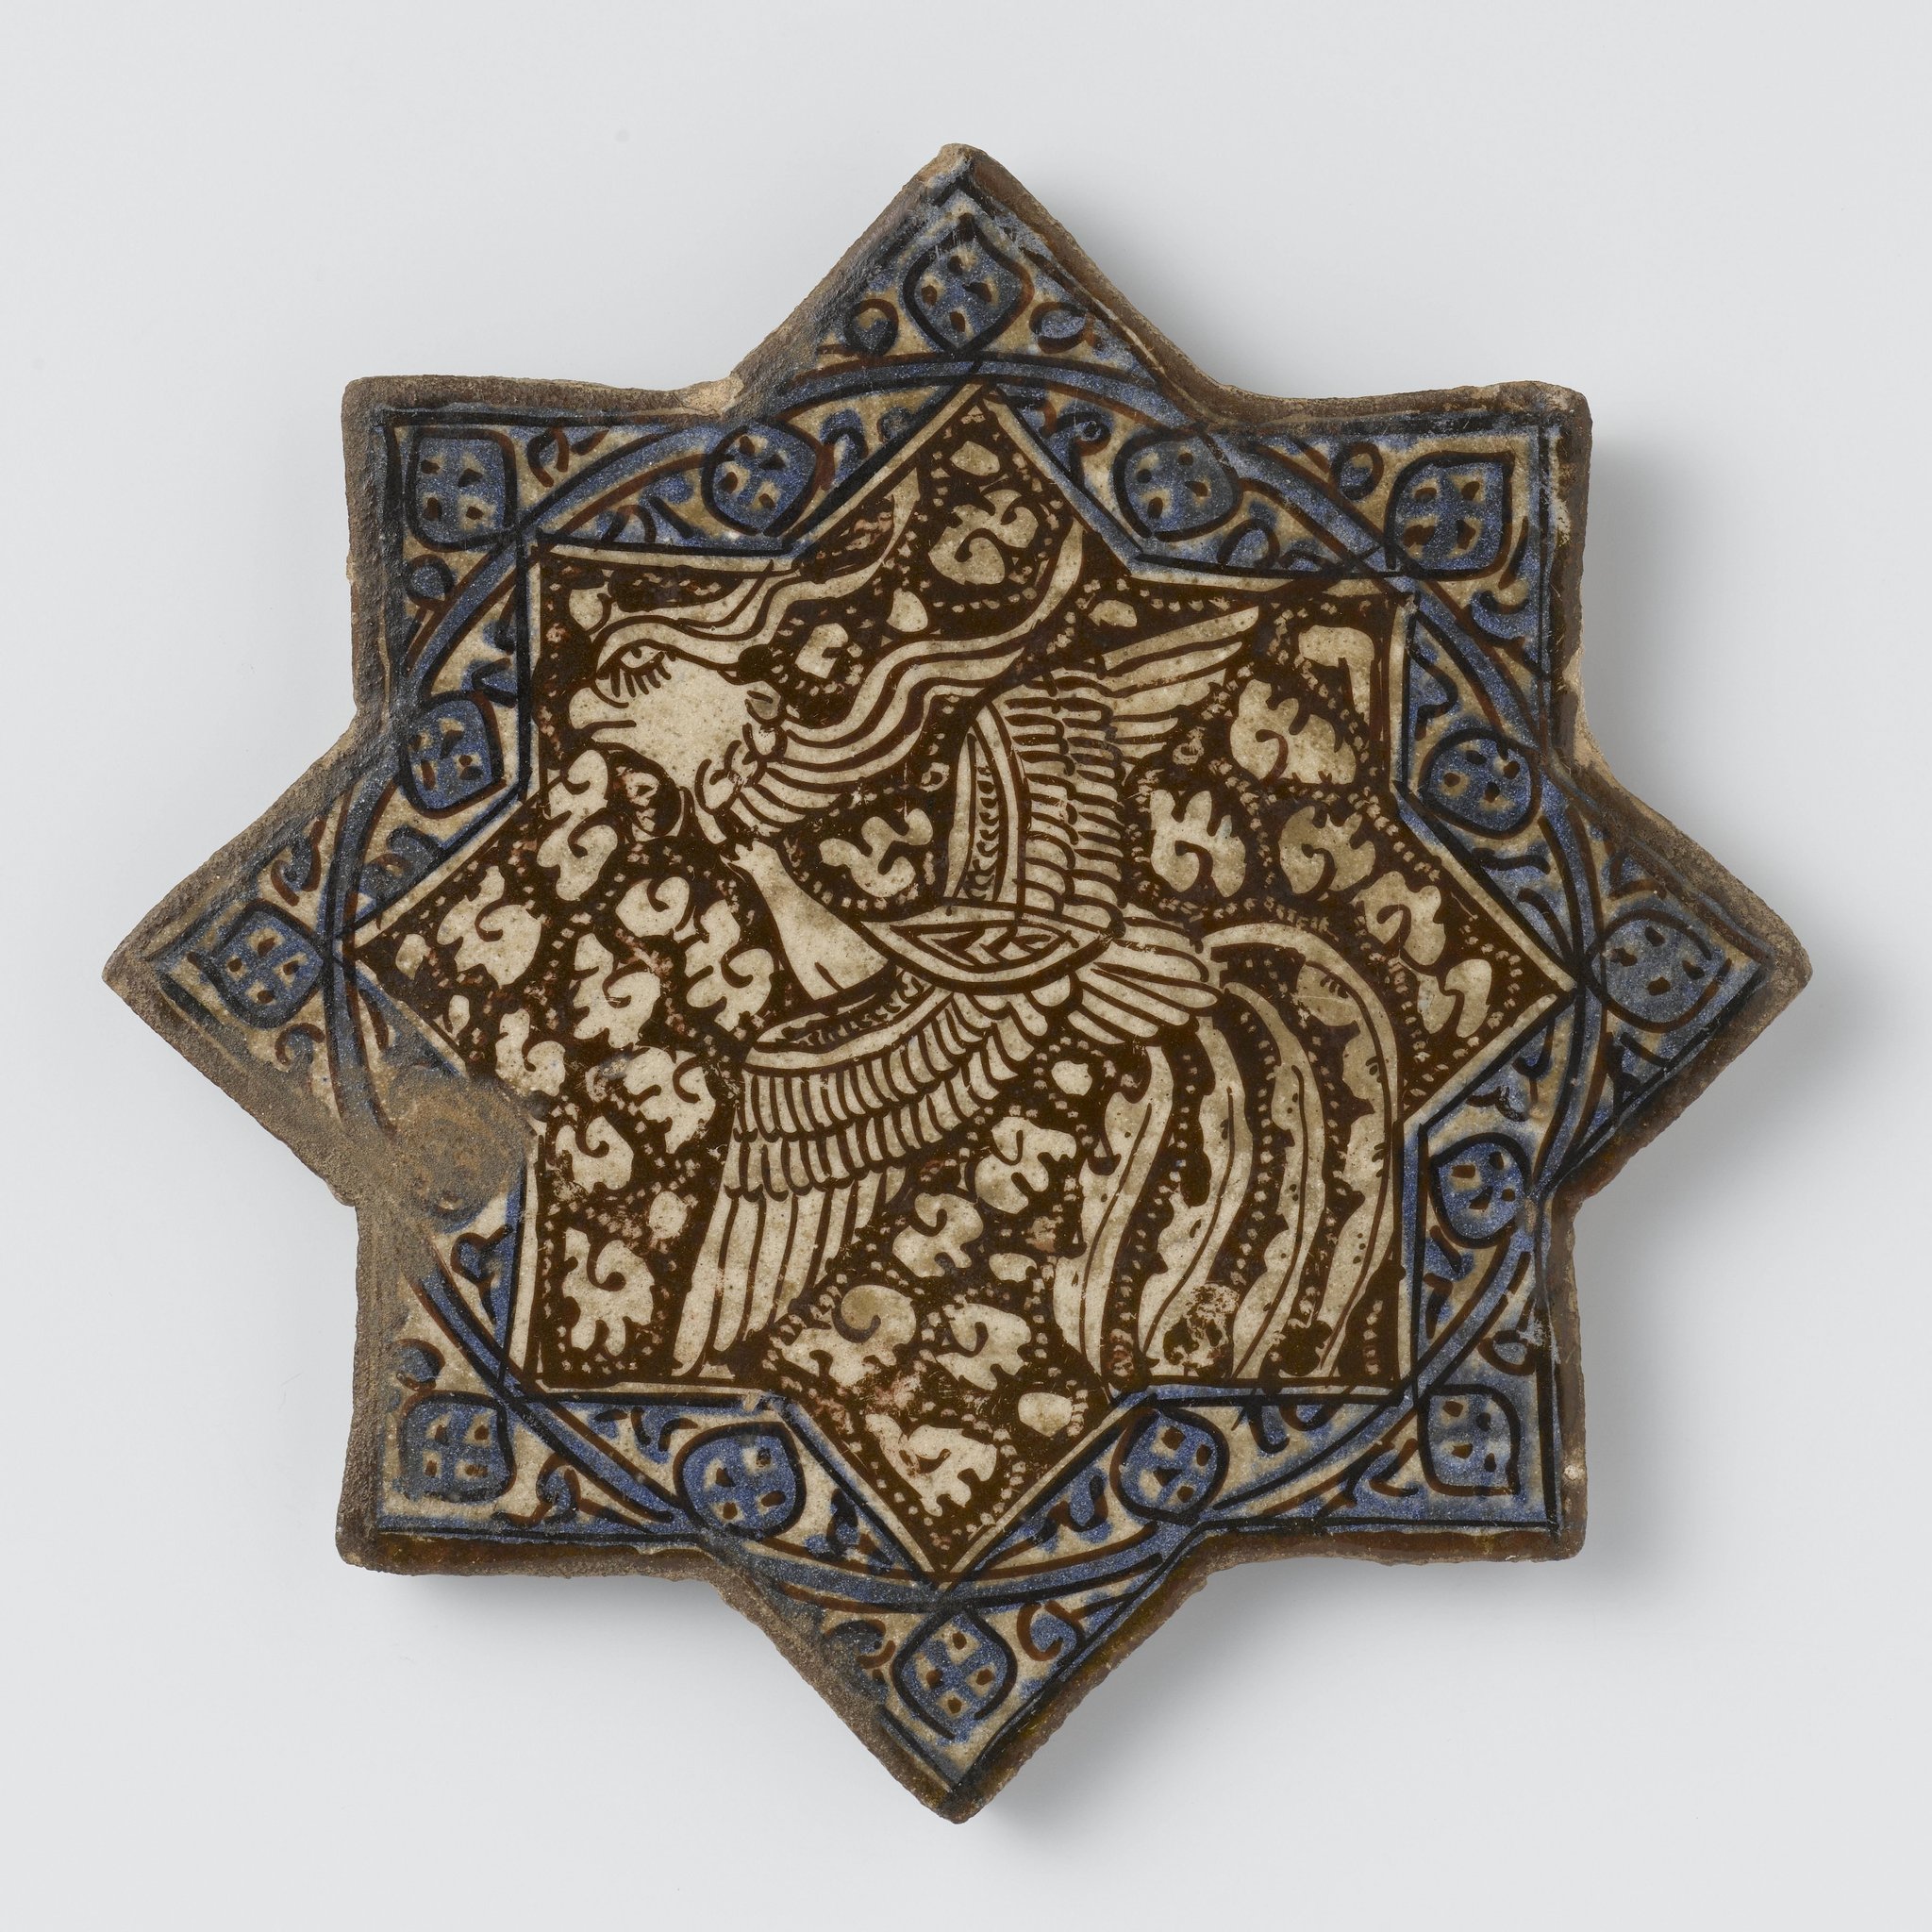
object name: stertegel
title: Star-shaped tile with a phoenix and stylized flower spray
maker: Anonymous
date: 1250-1324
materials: earthenware, glaze, luster, paint, quartz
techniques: firing, forming, vitrification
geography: kashan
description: Stervormige tegel van kwarts-fritgoed met acht punten, gedecoreerd met een feniks en gestileerde bloemtak in luster en blauw op ondergrond van witte glazuur.